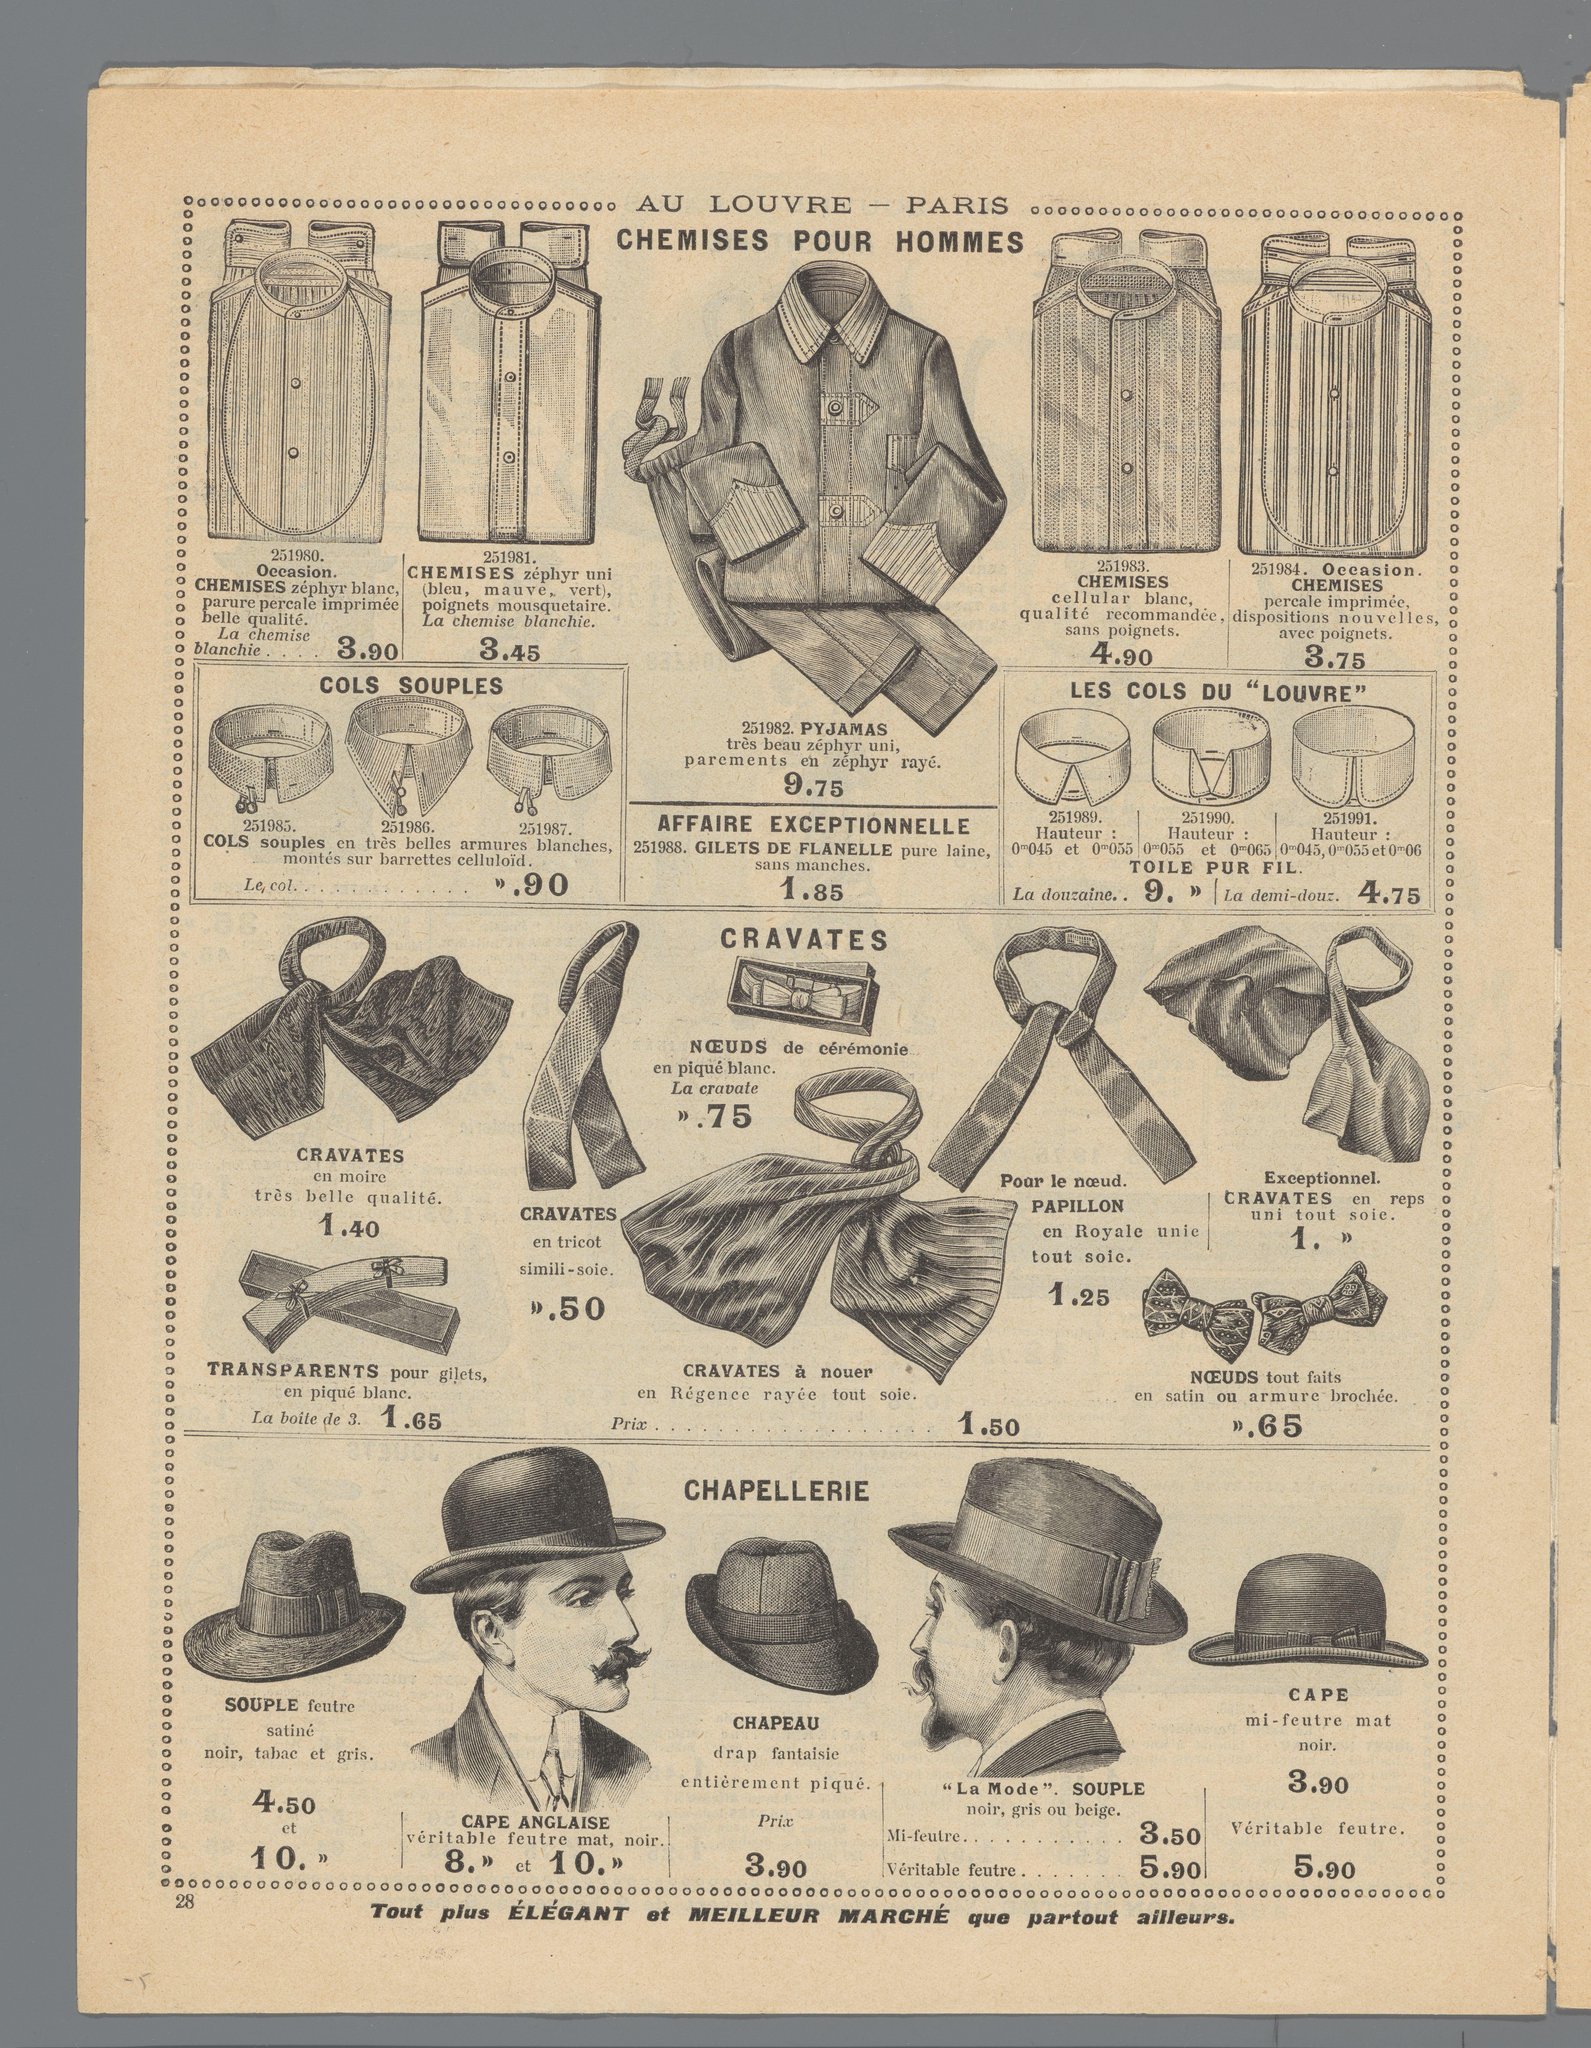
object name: print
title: Au Louvre, Paris: Lundi 2 Mars: Nouveautés d'été: pagina 28: advertenties van herenhoeden, dassen en strikjes, boorden en overhemden.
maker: Anonymous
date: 1913-1915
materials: paper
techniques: photography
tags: fashion plates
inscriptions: title: ‘Au Louvre, Paris: Lundi 2 Mars: Nouveautés d'été’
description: Pagina in "Au Louvre - Paris" :pagina 28: advertenties van herenhoeden, dassen en strikjes, boorden en overhemden.